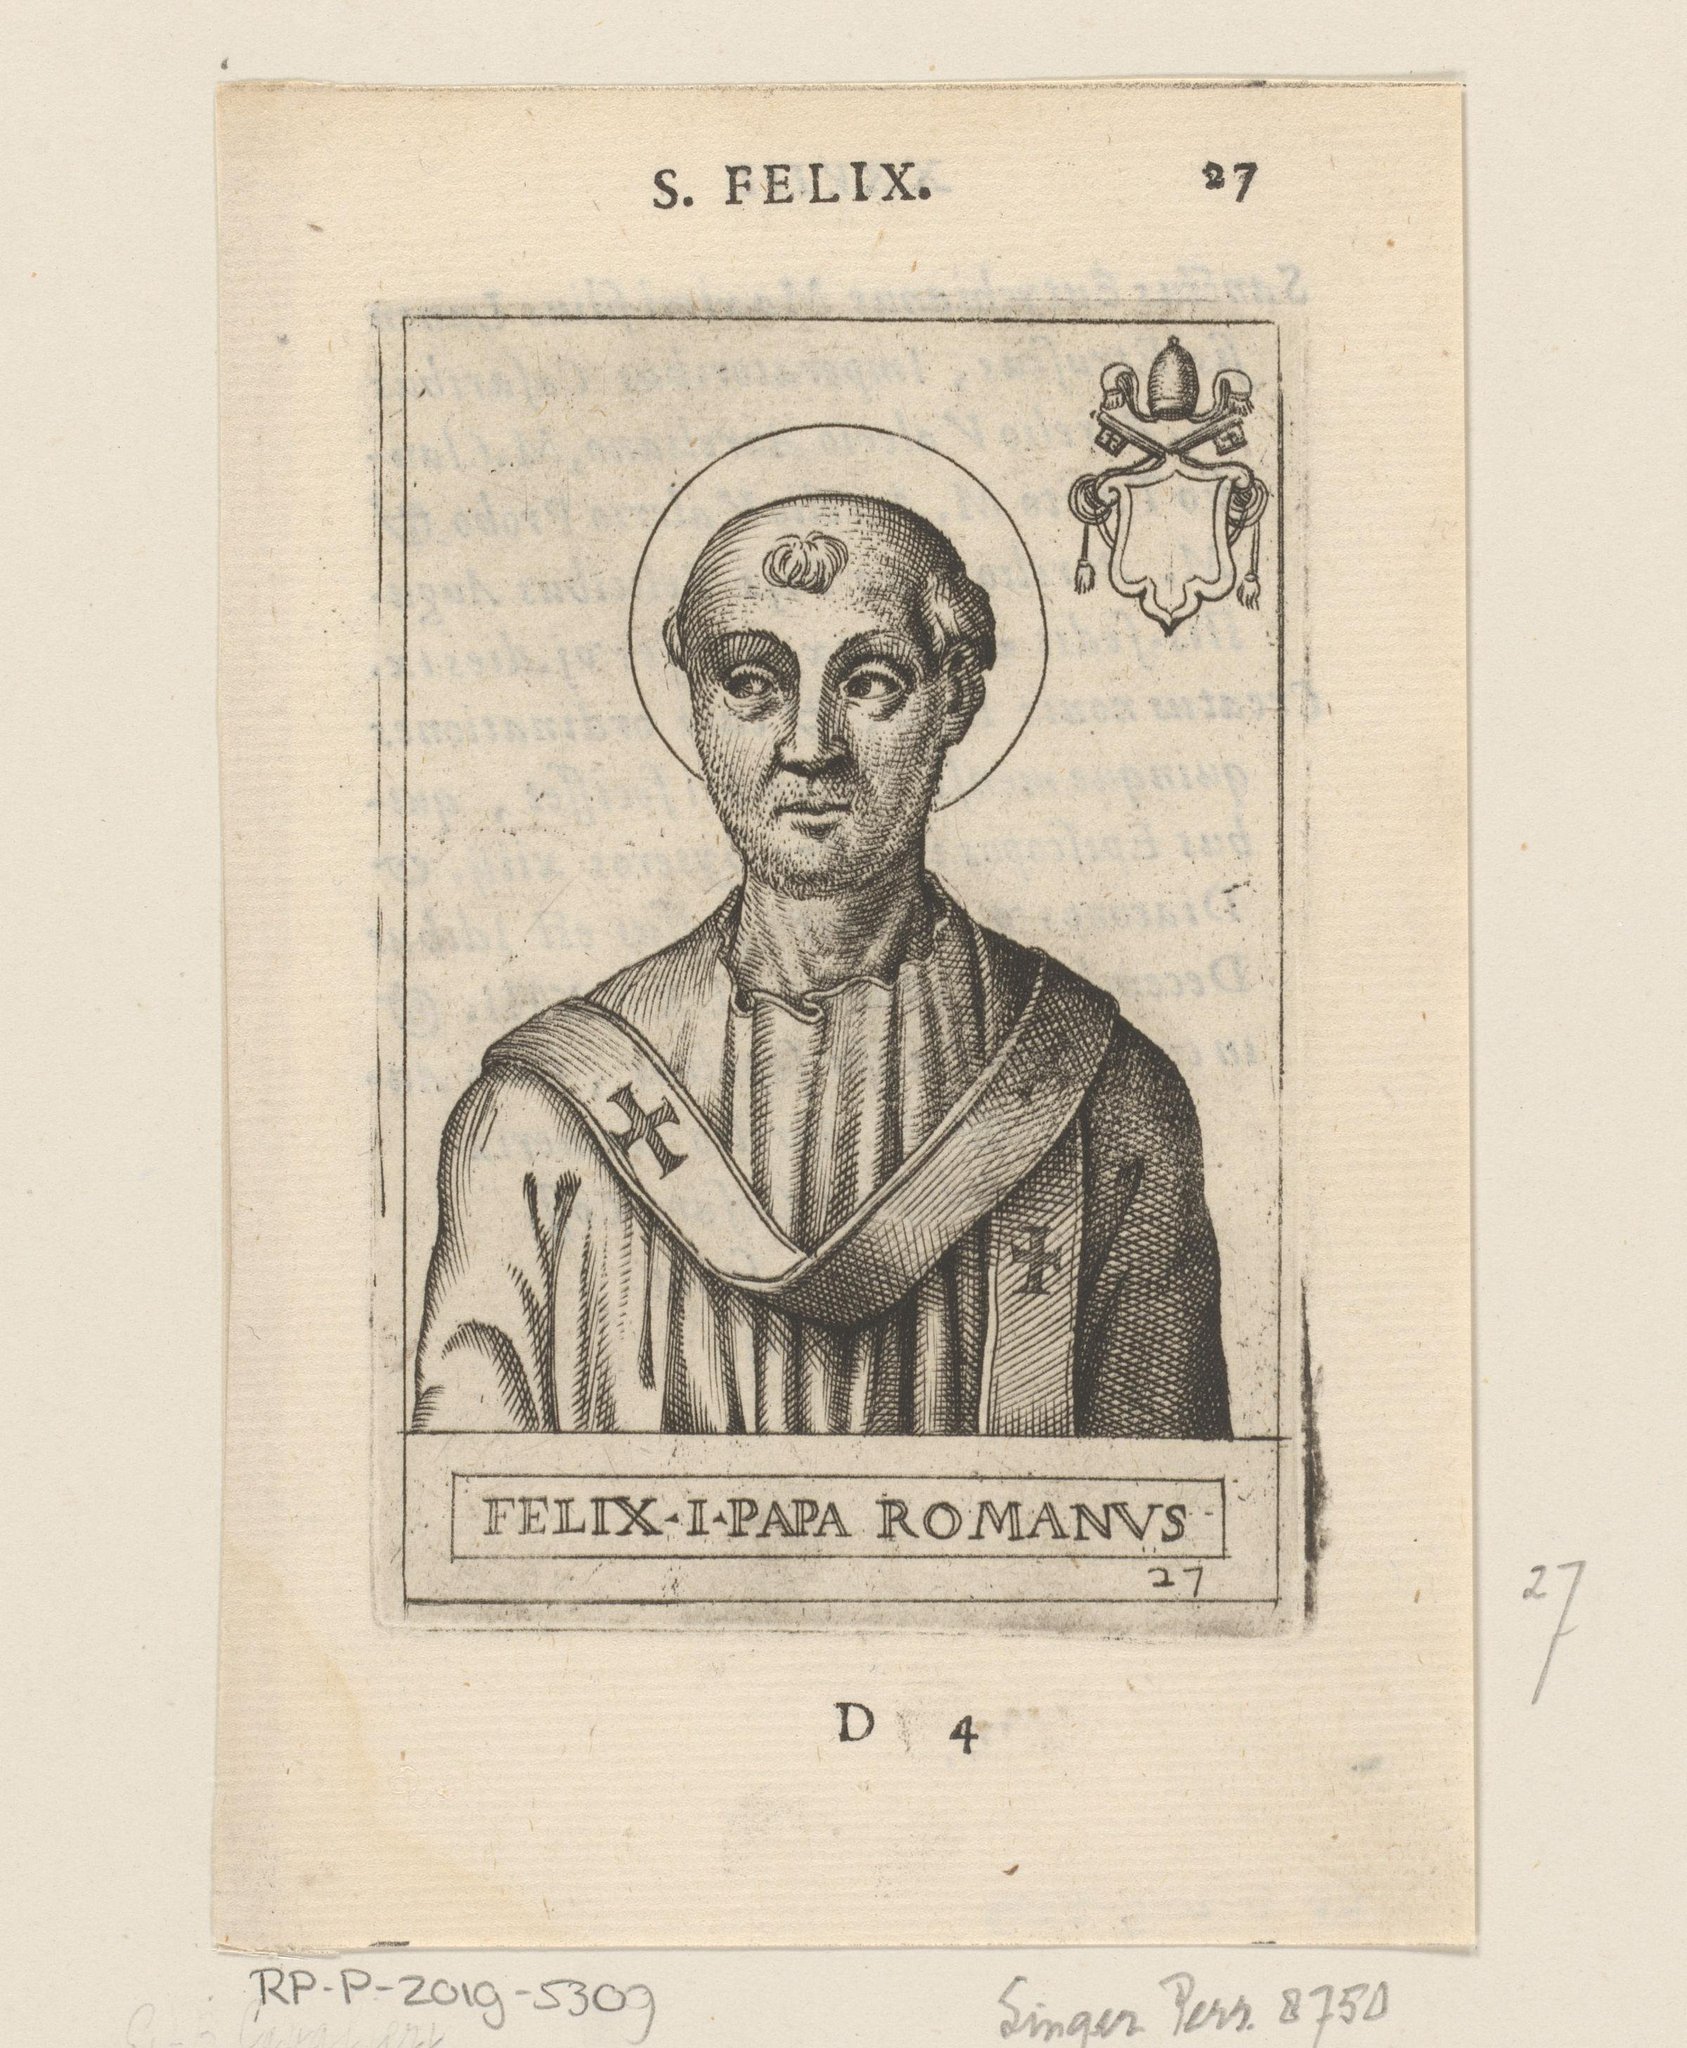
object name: book illustration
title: Felix I Papa Romanus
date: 1595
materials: paper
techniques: engraving, letterpress printing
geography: rome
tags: historical persons, pope, armorial bearing, heraldry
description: Prent uit: Cavalieri, Giovanni Battista de'. Effigies pontificum romanorum cum eorum vitis (...). Rome: Bartolomeo Bonfadino, 1595. Prent voor het eerst verschenen in: Cavalieri, Giovanni Battista de'. Pontificum romanorum effigies (...). Rome: Domenico Basa en Francesco Zanetti, 1580. Prent ook gebruikt in latere publicaties.